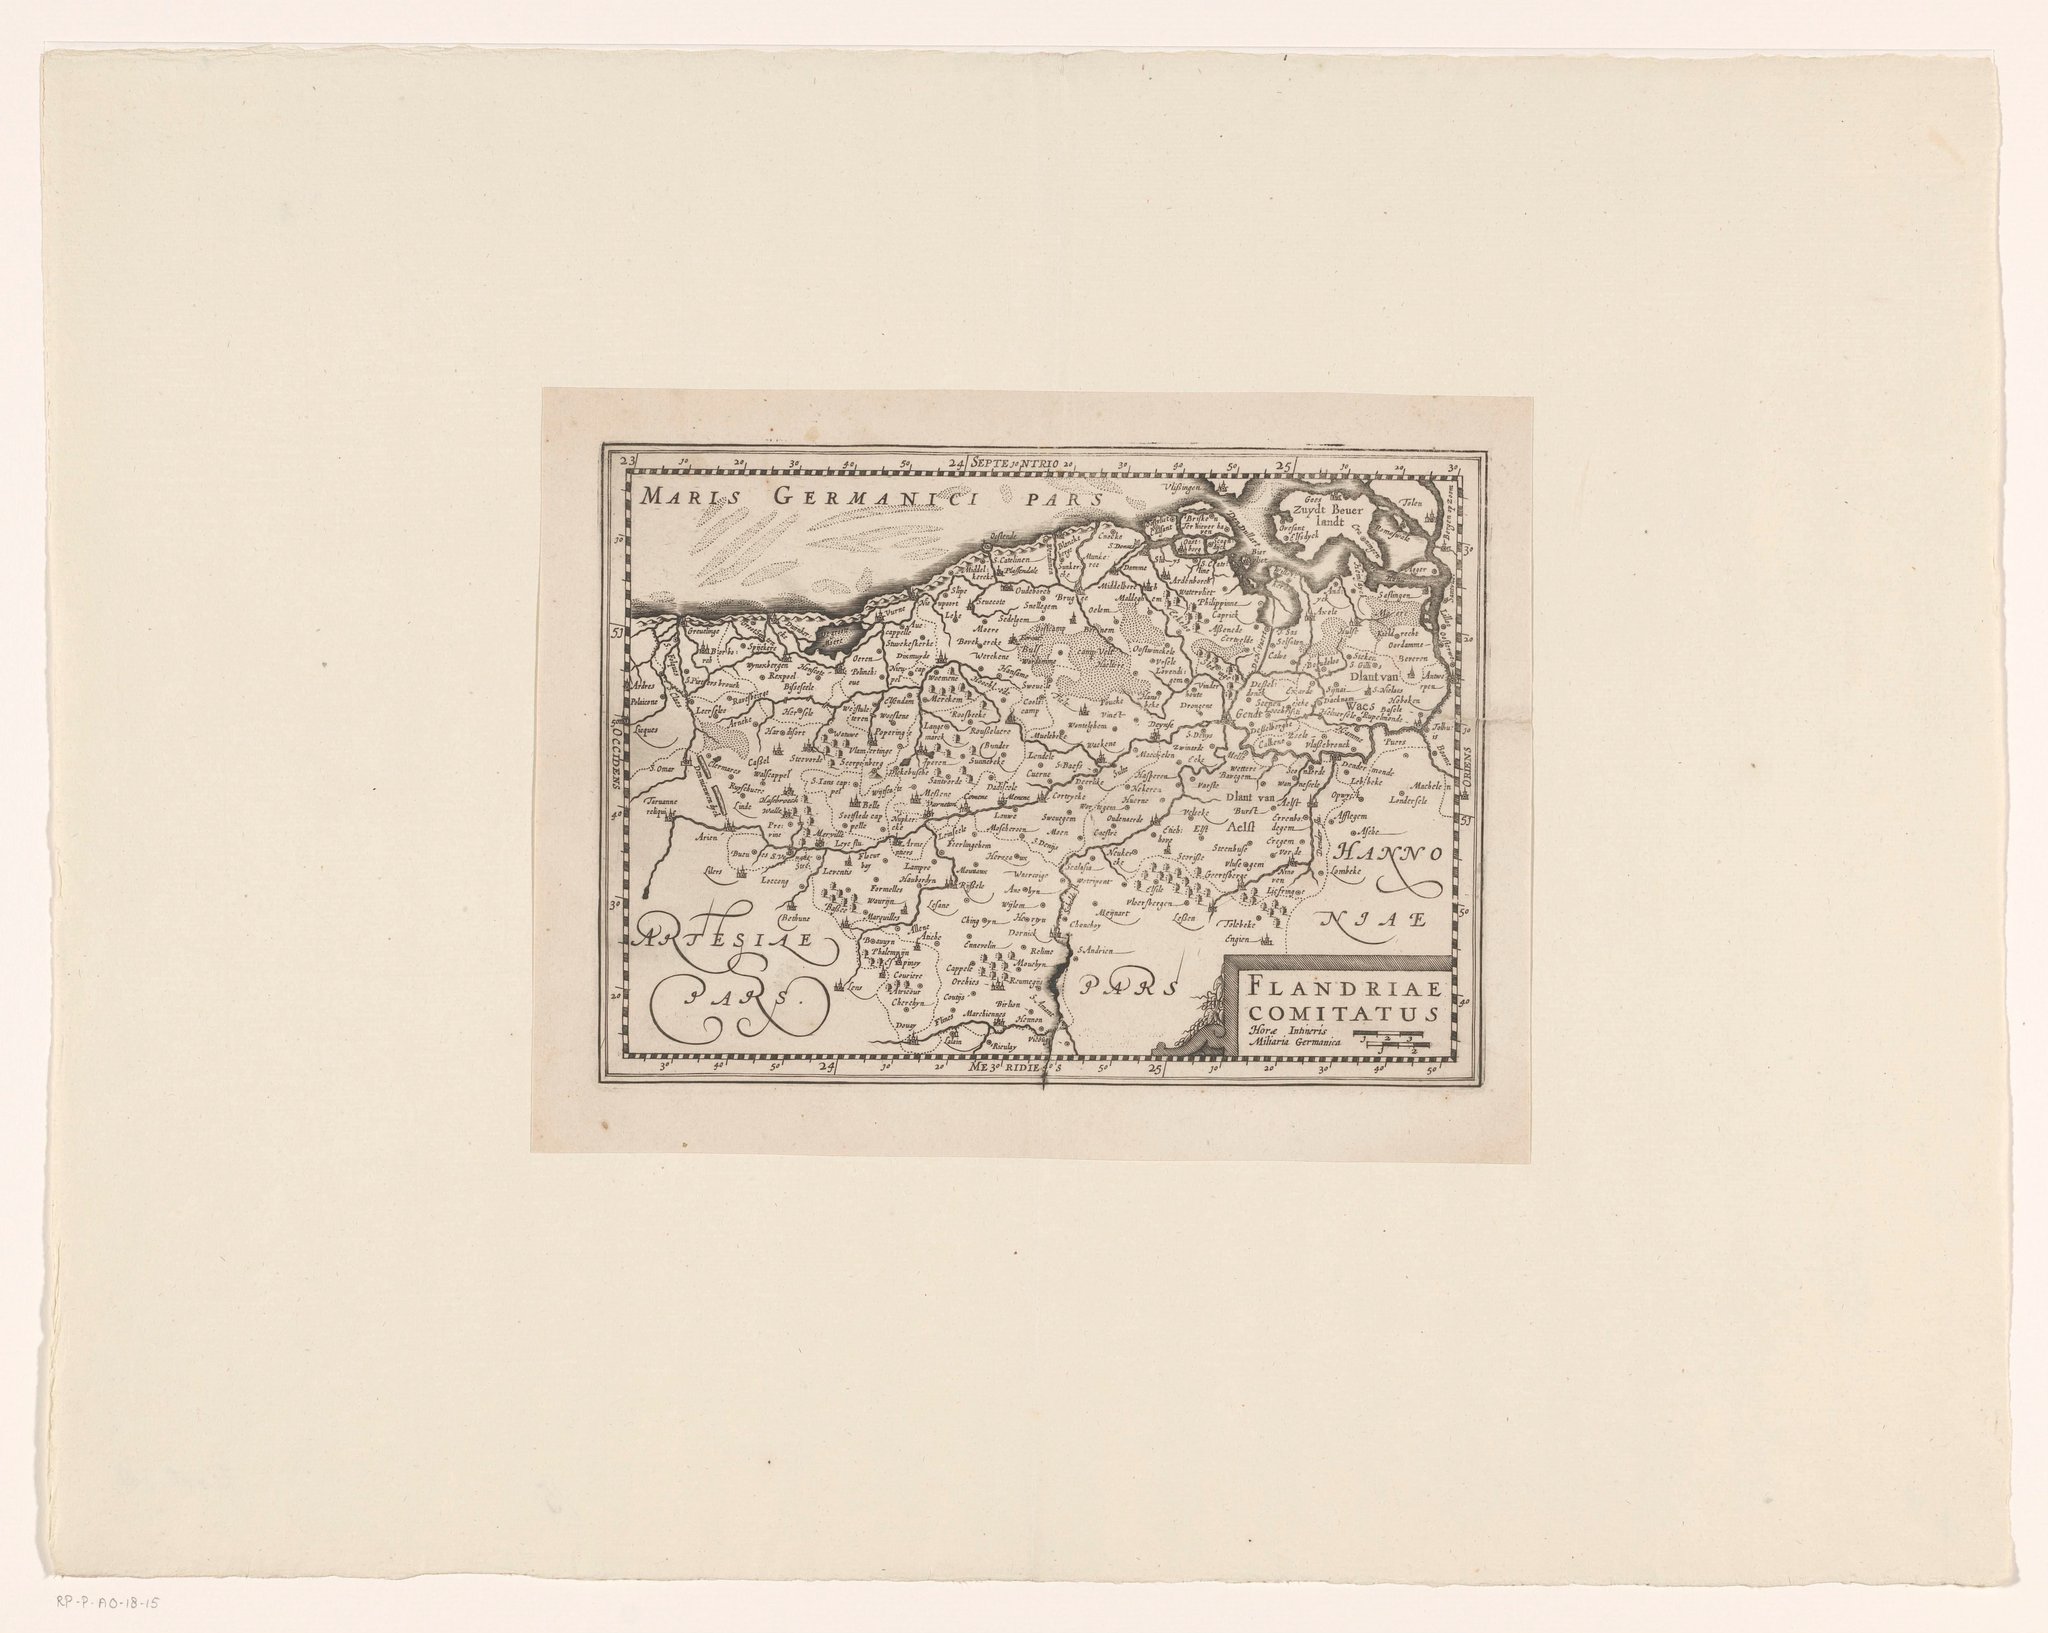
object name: map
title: Flandriae comitatus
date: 1673-1676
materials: paper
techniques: engraving, etching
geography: amsterdam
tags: maps of separate countries or regions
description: Prent ook gebruikt in: Atlas sive Cosmographicae meditationes de fabrica mundi et fabricati figura (…). Amsterdam: Johannes Janssonius van Waesbergen,1673. En in: Nieuwe en beknopte Uytbeeldinge en Vertooninge der gantscher Aerdbodem. Amsterdam: Johannes Janssoniuss van Waesbergen, 1676.